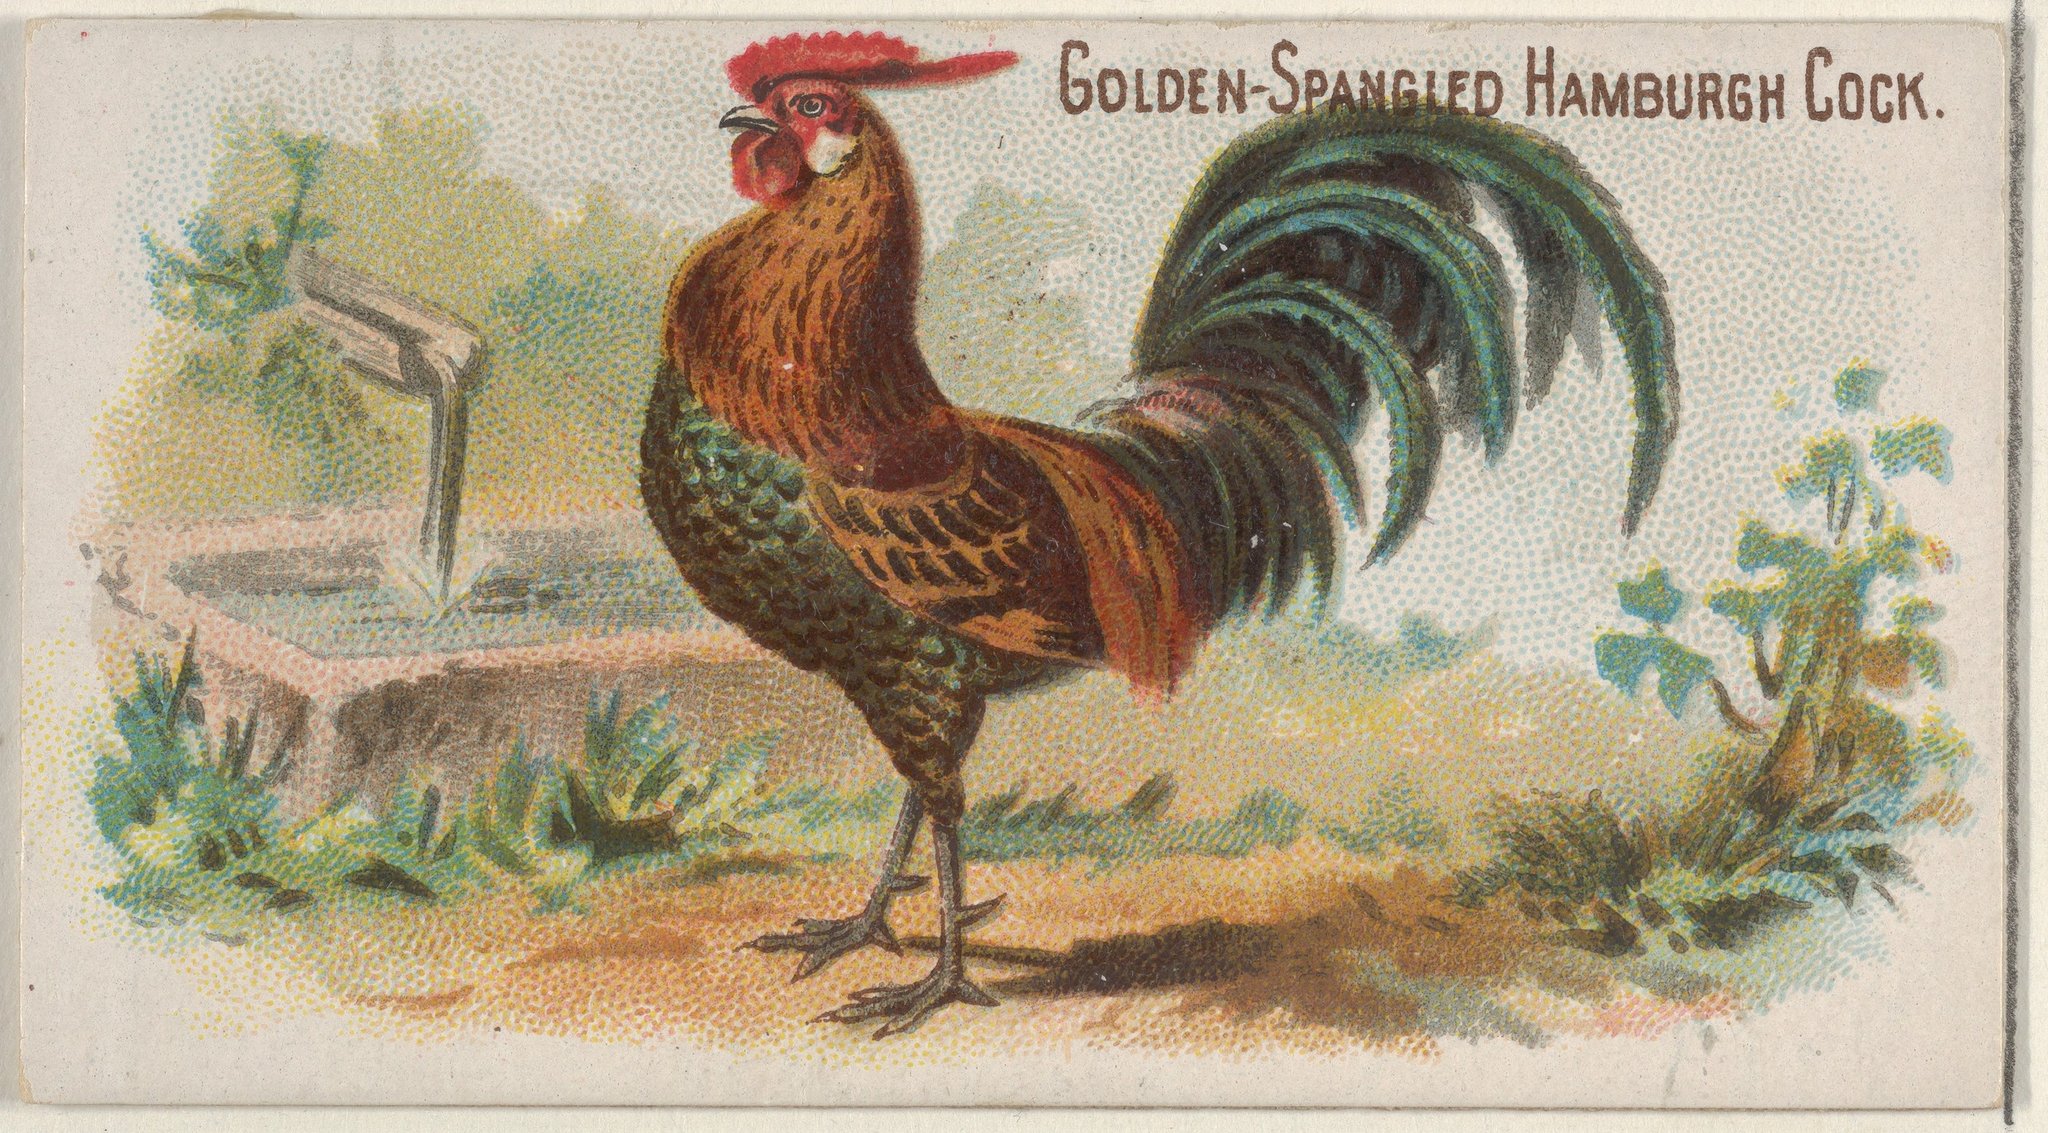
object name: print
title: Golden-Spangled Hamburgh Cock, from the Prize and Game Chickens series (N20) for Allen & Ginter Cigarettes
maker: allen & ginter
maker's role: publisher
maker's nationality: american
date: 1891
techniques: color lithograph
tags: roosters